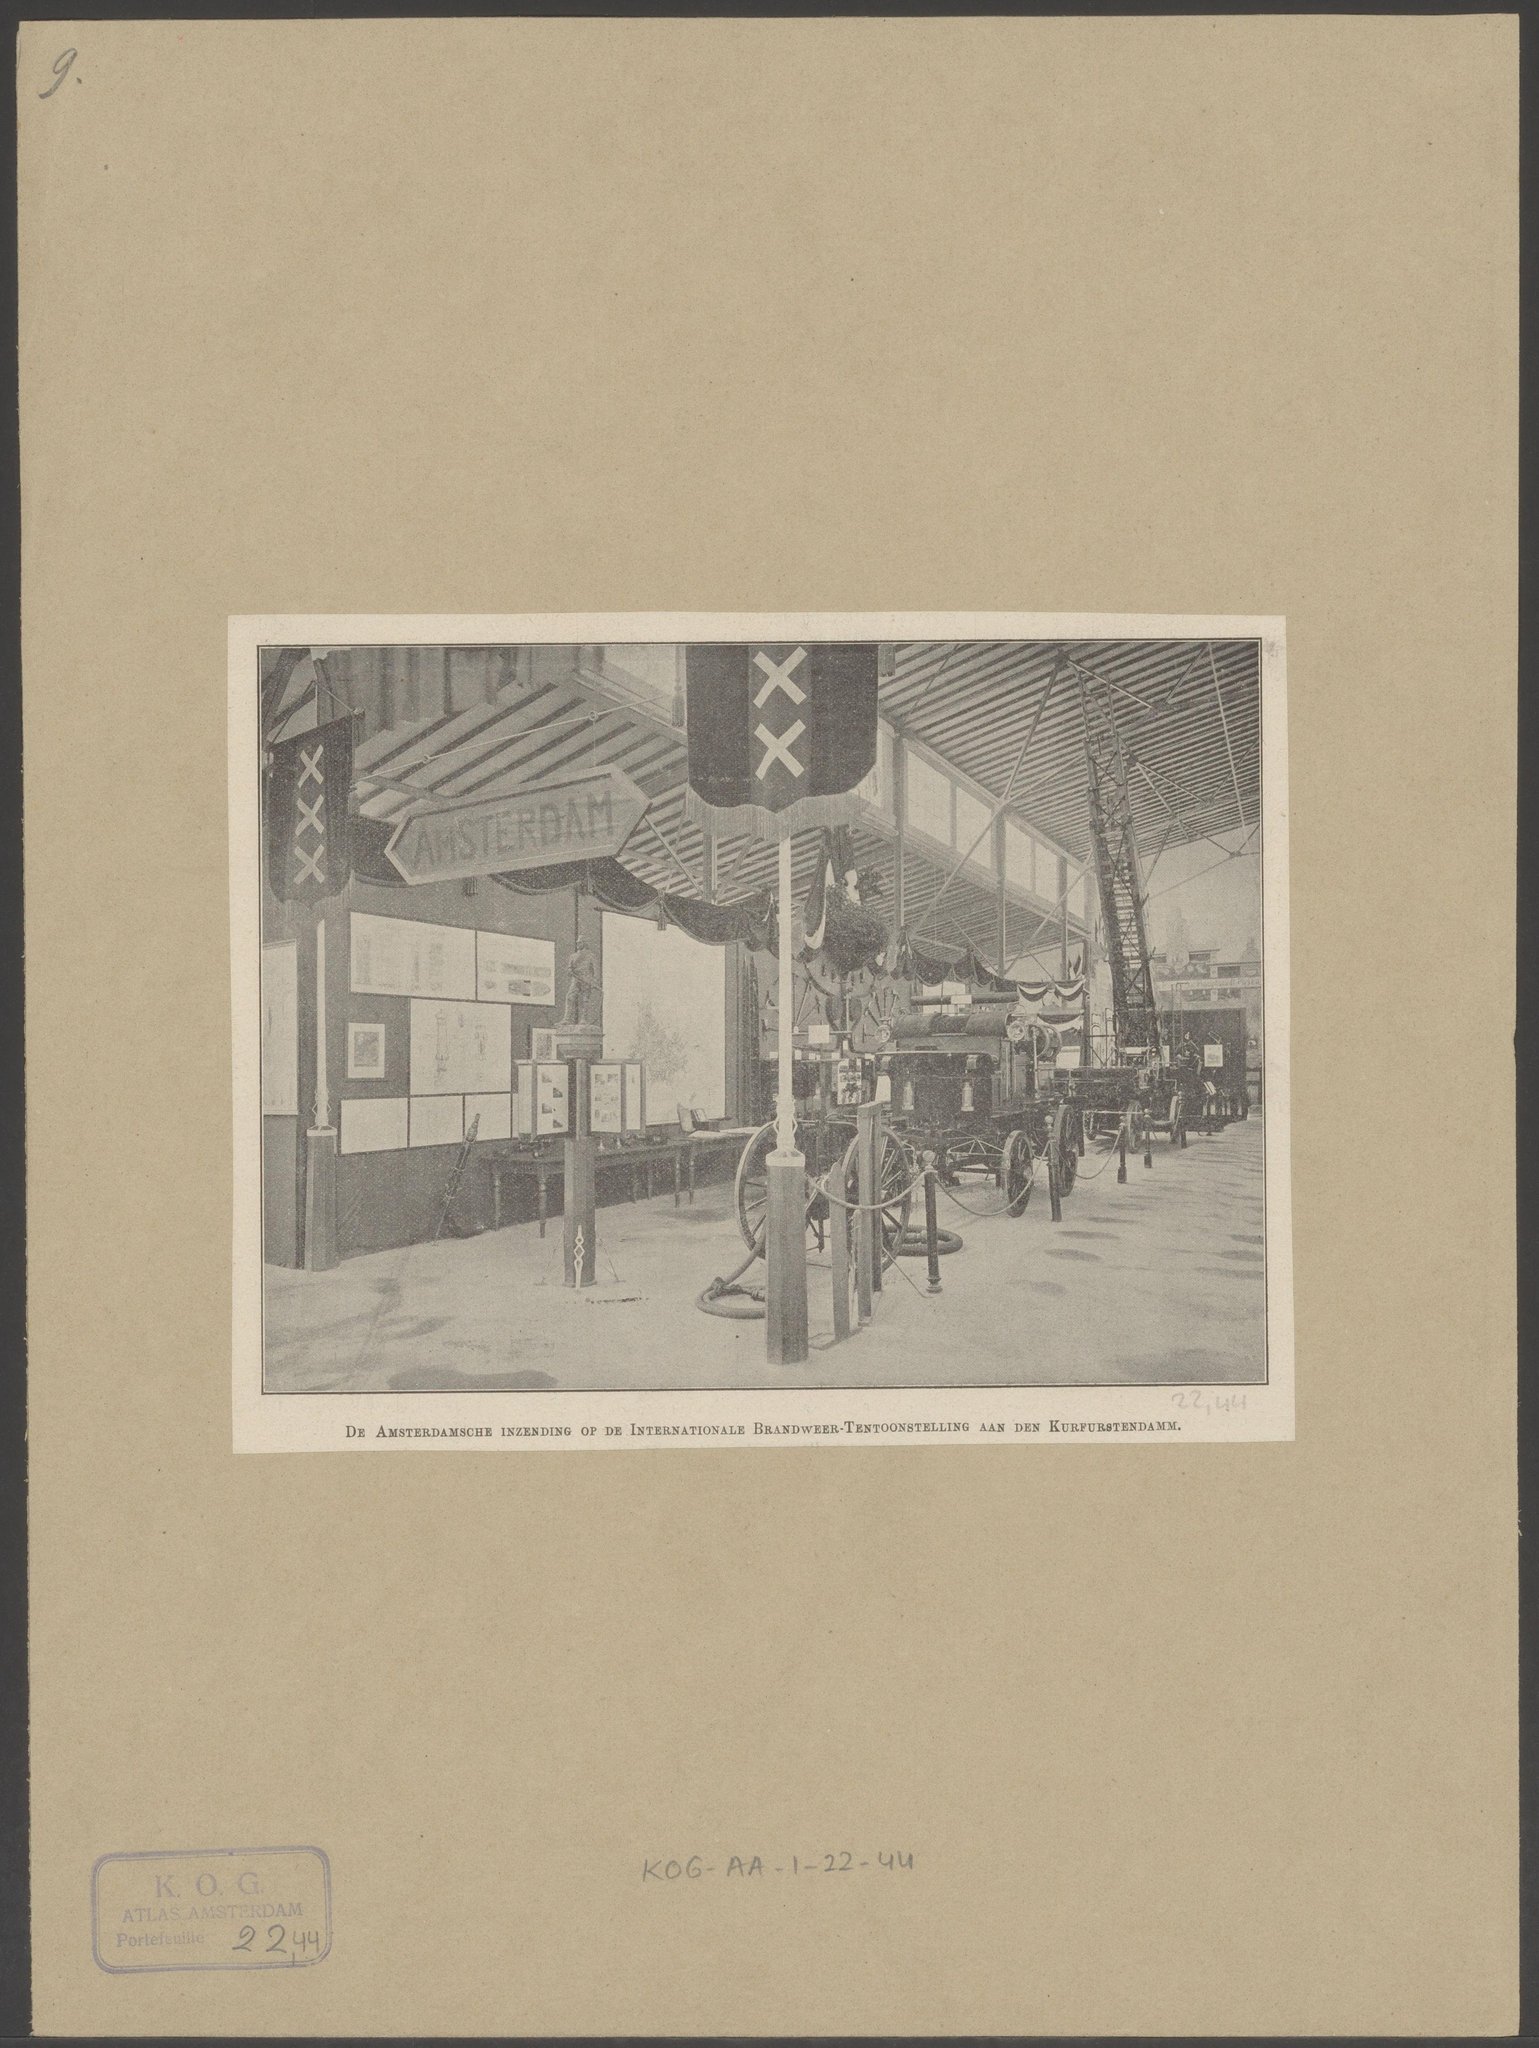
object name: photomechanical print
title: Tentoonstelling van brandweermateriaal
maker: Anonymous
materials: paper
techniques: letterpress printing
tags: coat of arms (as symbol of the state, etc.) (+ city; municipal), fire-extinguishing equipment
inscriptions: collector's mark: Lugt 1641b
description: Onderwerpsrubriek binnen de Atlas Amsterdam: Gemeentewerken: A. Brandweer.